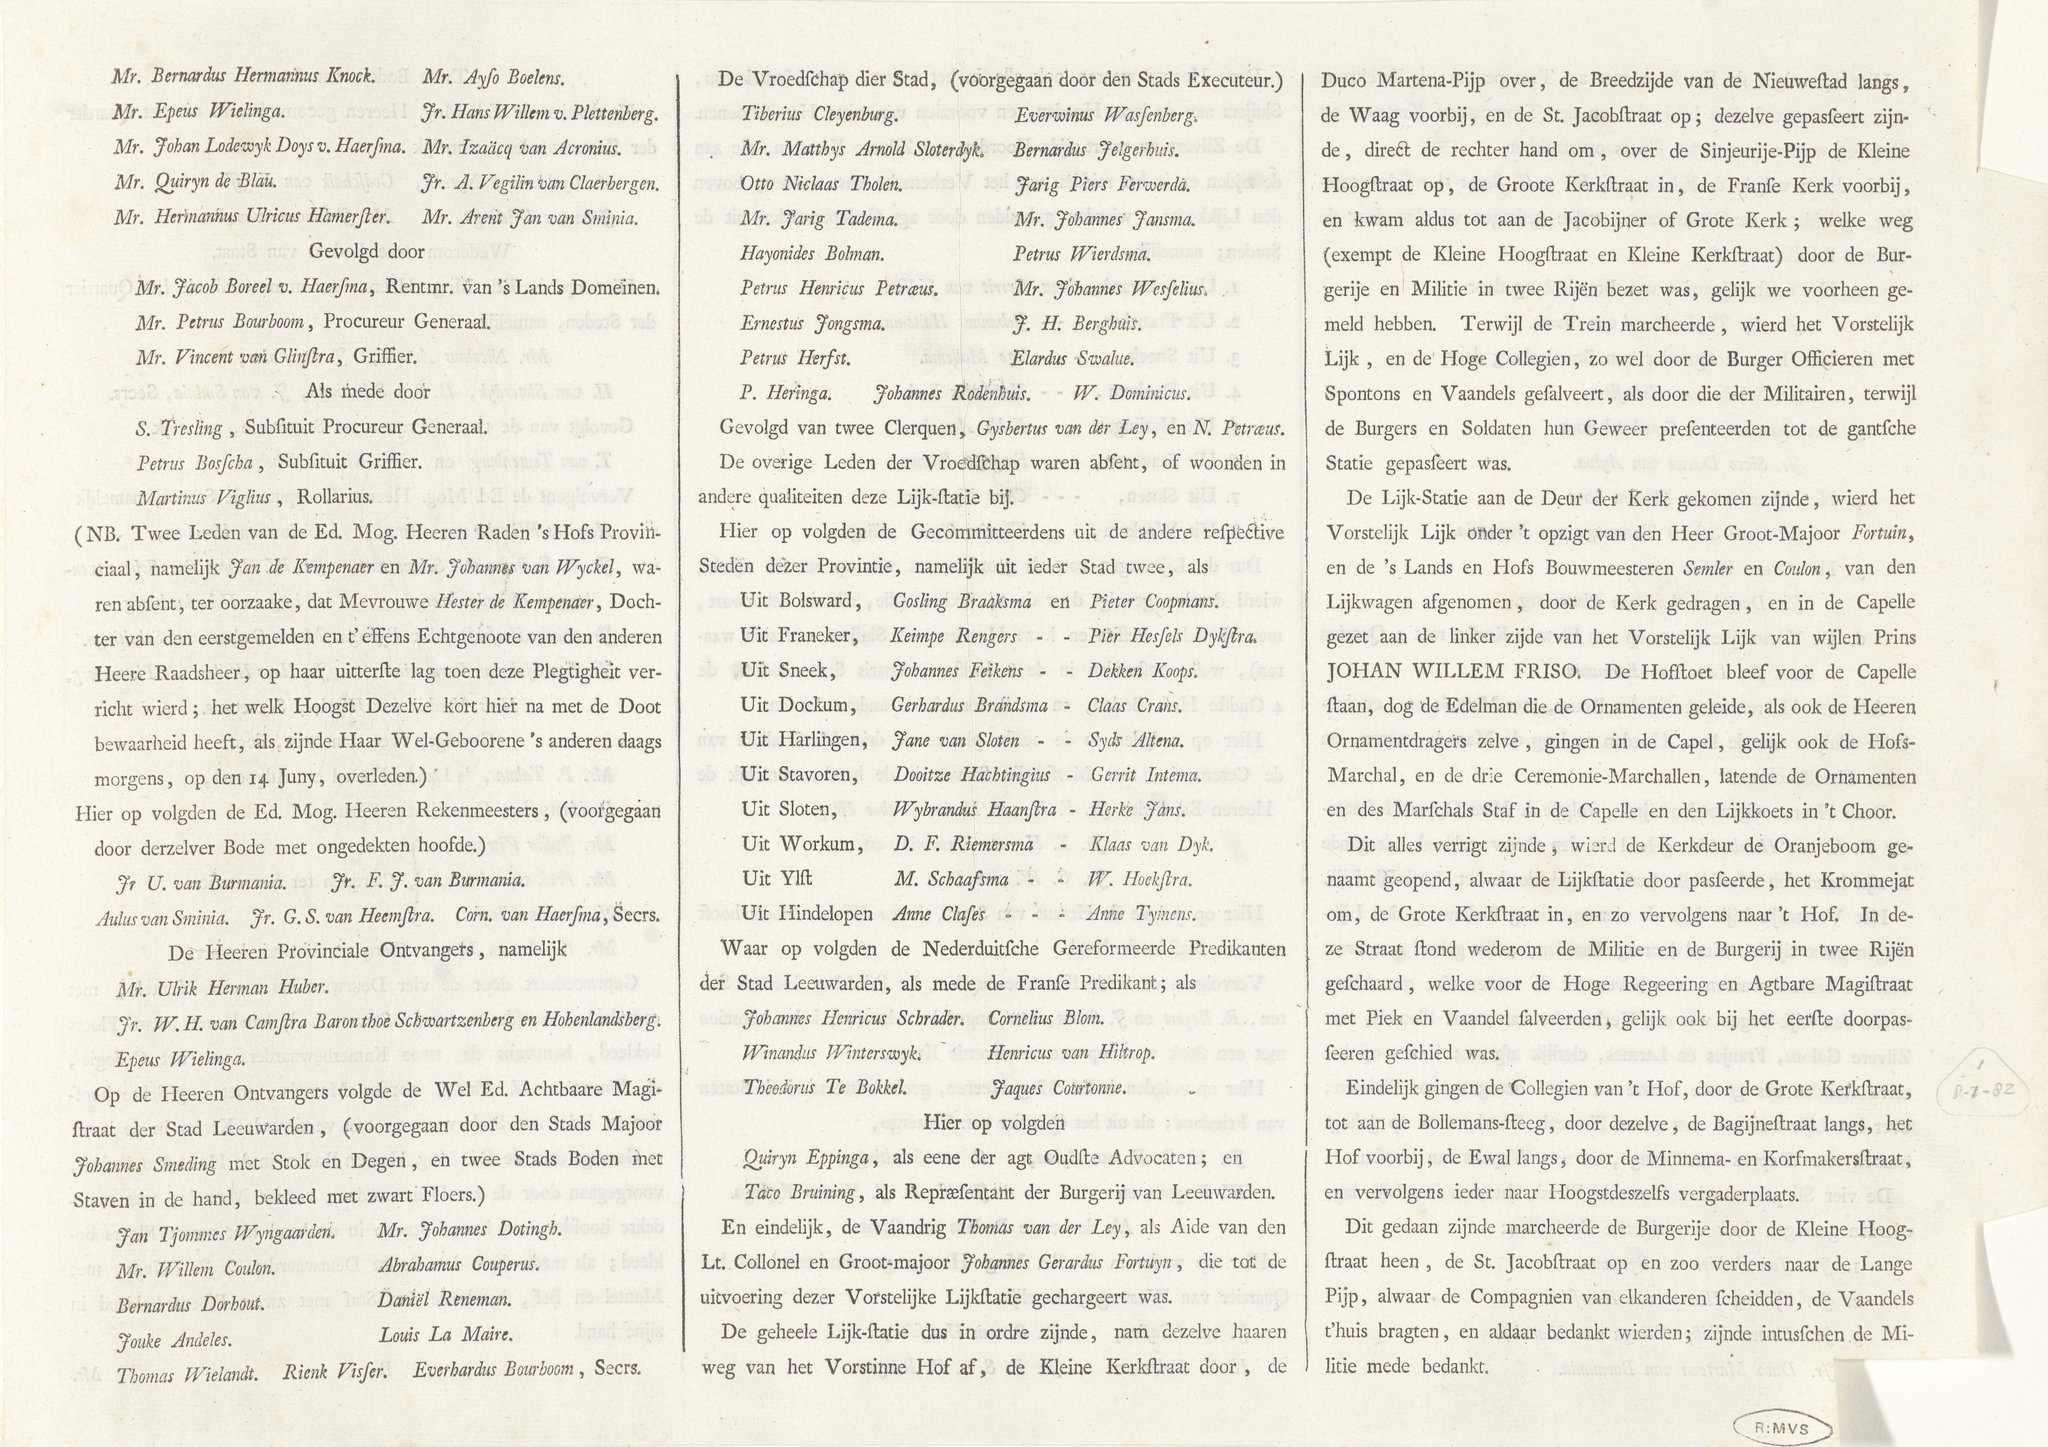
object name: text sheet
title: Lijkstatie van prinses Maria Louise, 1765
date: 1765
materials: paper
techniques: letterpress printing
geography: leeuwarden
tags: kassel, leeuwarden, maria louisa van hessen-kassel, begrafenis van maria louise, prinses van oranje-nassau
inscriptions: collector's mark: Lugt 2228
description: Tekstblad met in drie kolommen een deel van de beschrijving van de lijkstatie. Gemerkt op de andere zijde rechtsonder: B. Onderdeel van de serie platen van de begrafenis van prinses Maria Louise te Leeuwarden op 13 juni 1765.